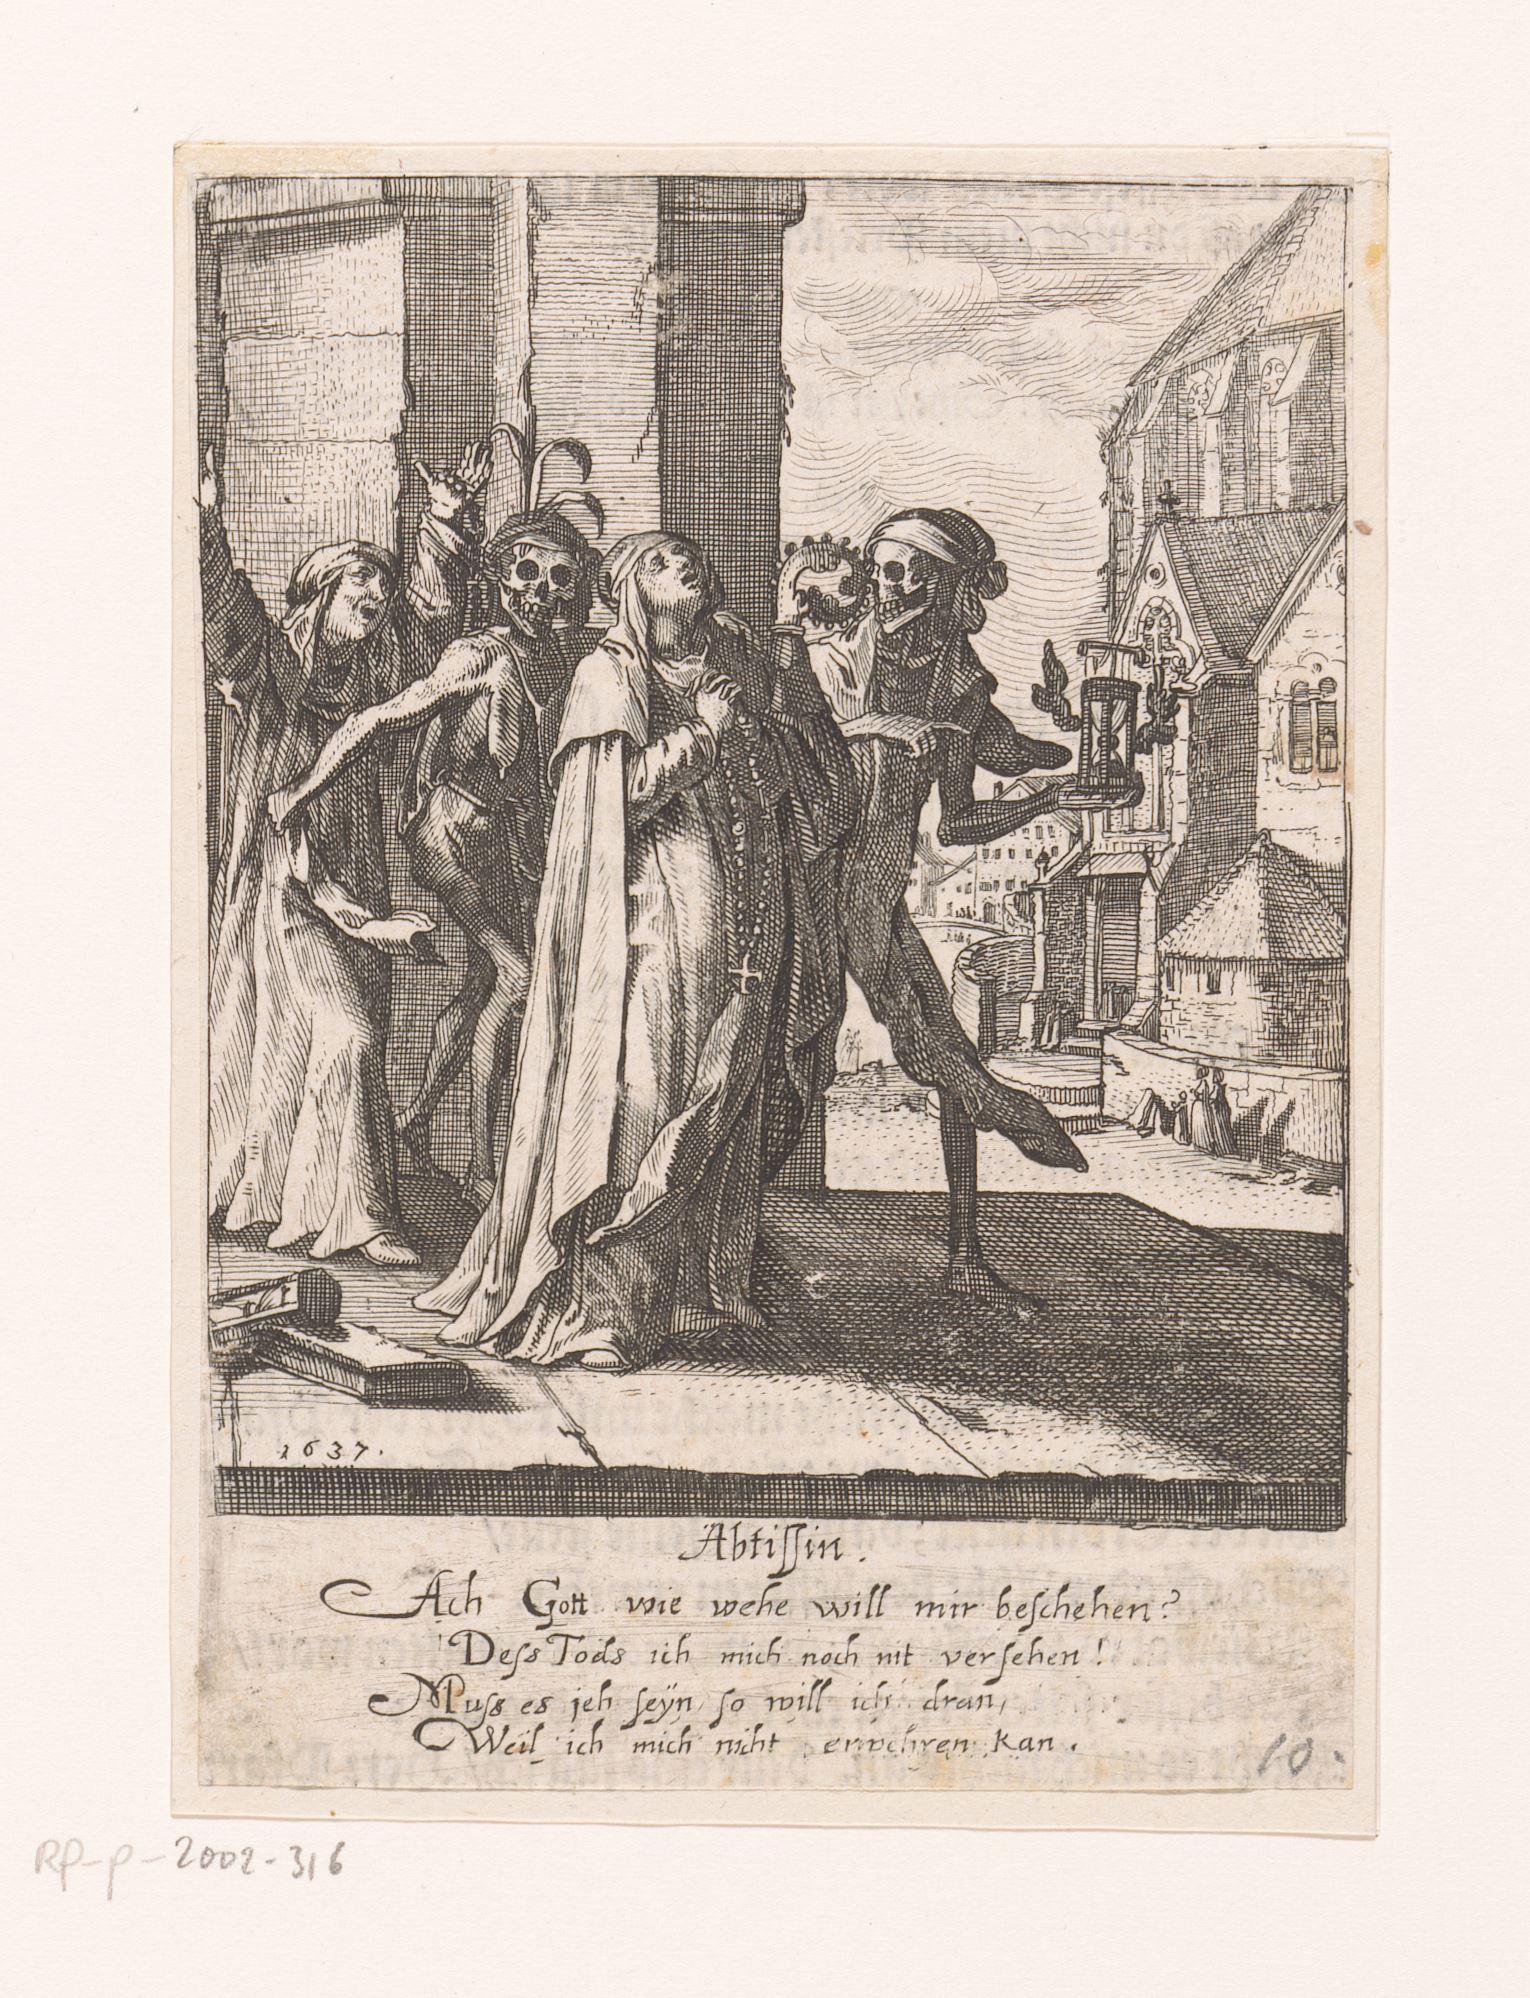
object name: print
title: De Dodendans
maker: johann jakob bodmer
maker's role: printer, publisher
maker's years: 1629-1650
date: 1650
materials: paper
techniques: etching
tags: abbot, personifications of death; 'morte' (ripa), dance of death; death together with one or more human beings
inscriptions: collector's mark: Lugt 2233, collector's mark: Lugt 2228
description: Een abdis loopt een gebouw uit, rozenkrans in de handen. Naast haar de Dood als skelet, met gevleugelde zandloper in de hand. Achter haar een tweede skelet en een non met opgeheven armen.